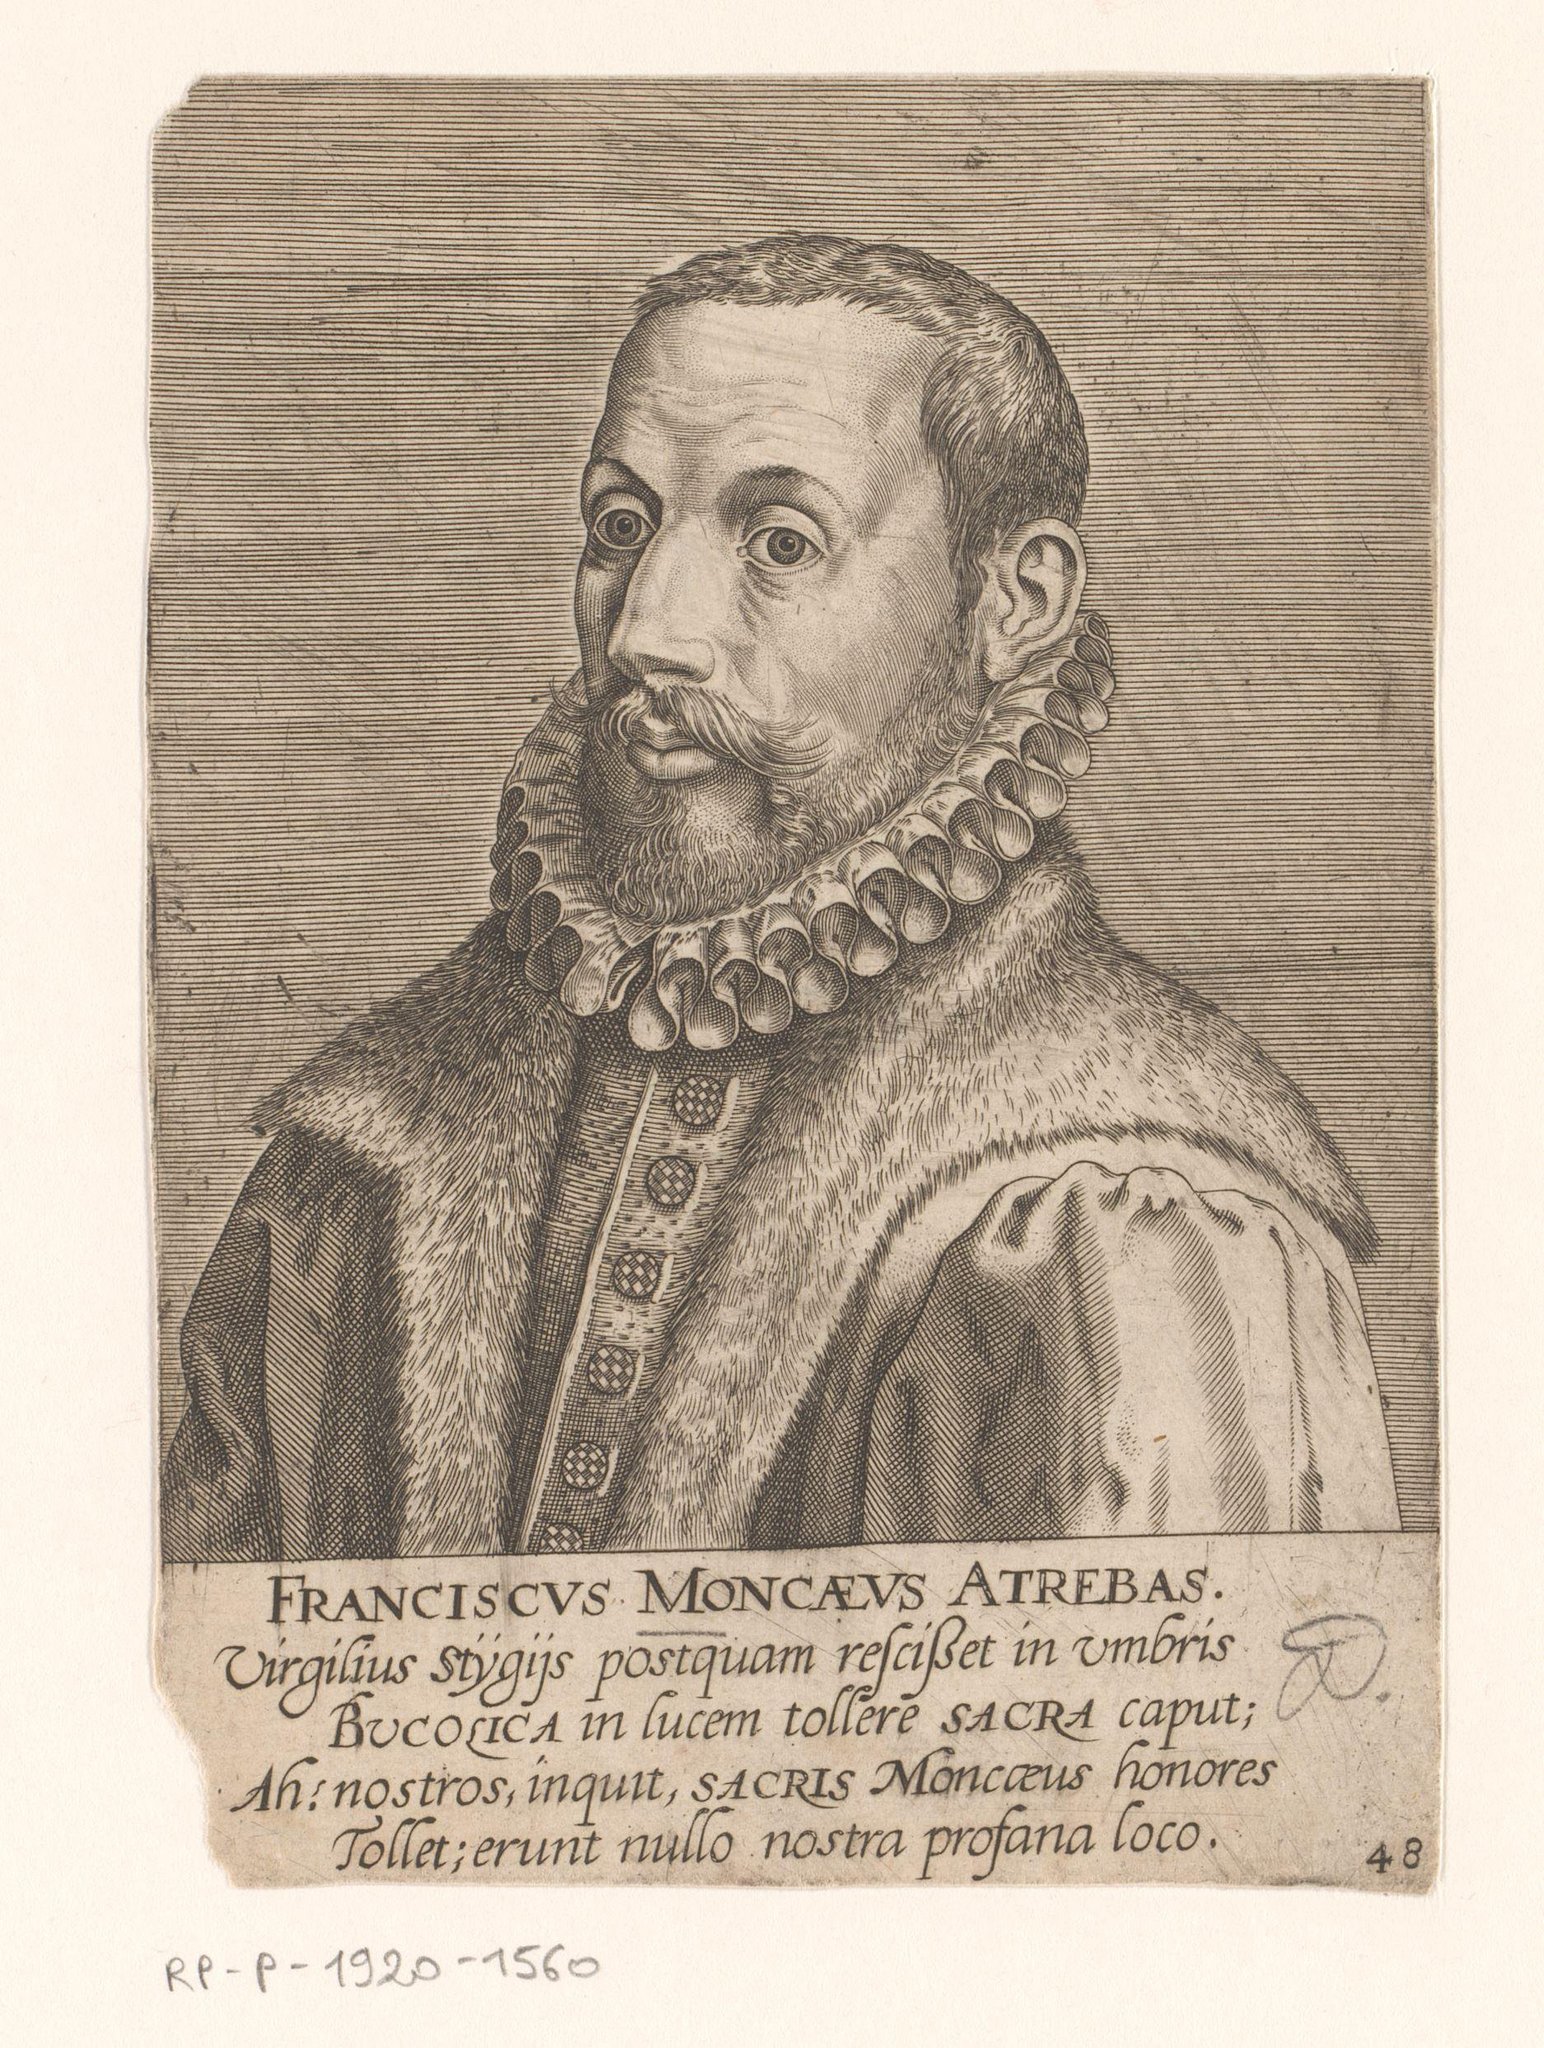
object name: print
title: Portretten van beroemde geleerden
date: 1587-1606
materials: paper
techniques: engraving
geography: antwerp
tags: historical persons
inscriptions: collector's mark: Lugt 2228, inscription: ‘in Franken aanwezig/ Gm’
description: Met vierregelig onderschrift in het Latijn. Rechtsonder genummerd: 48.